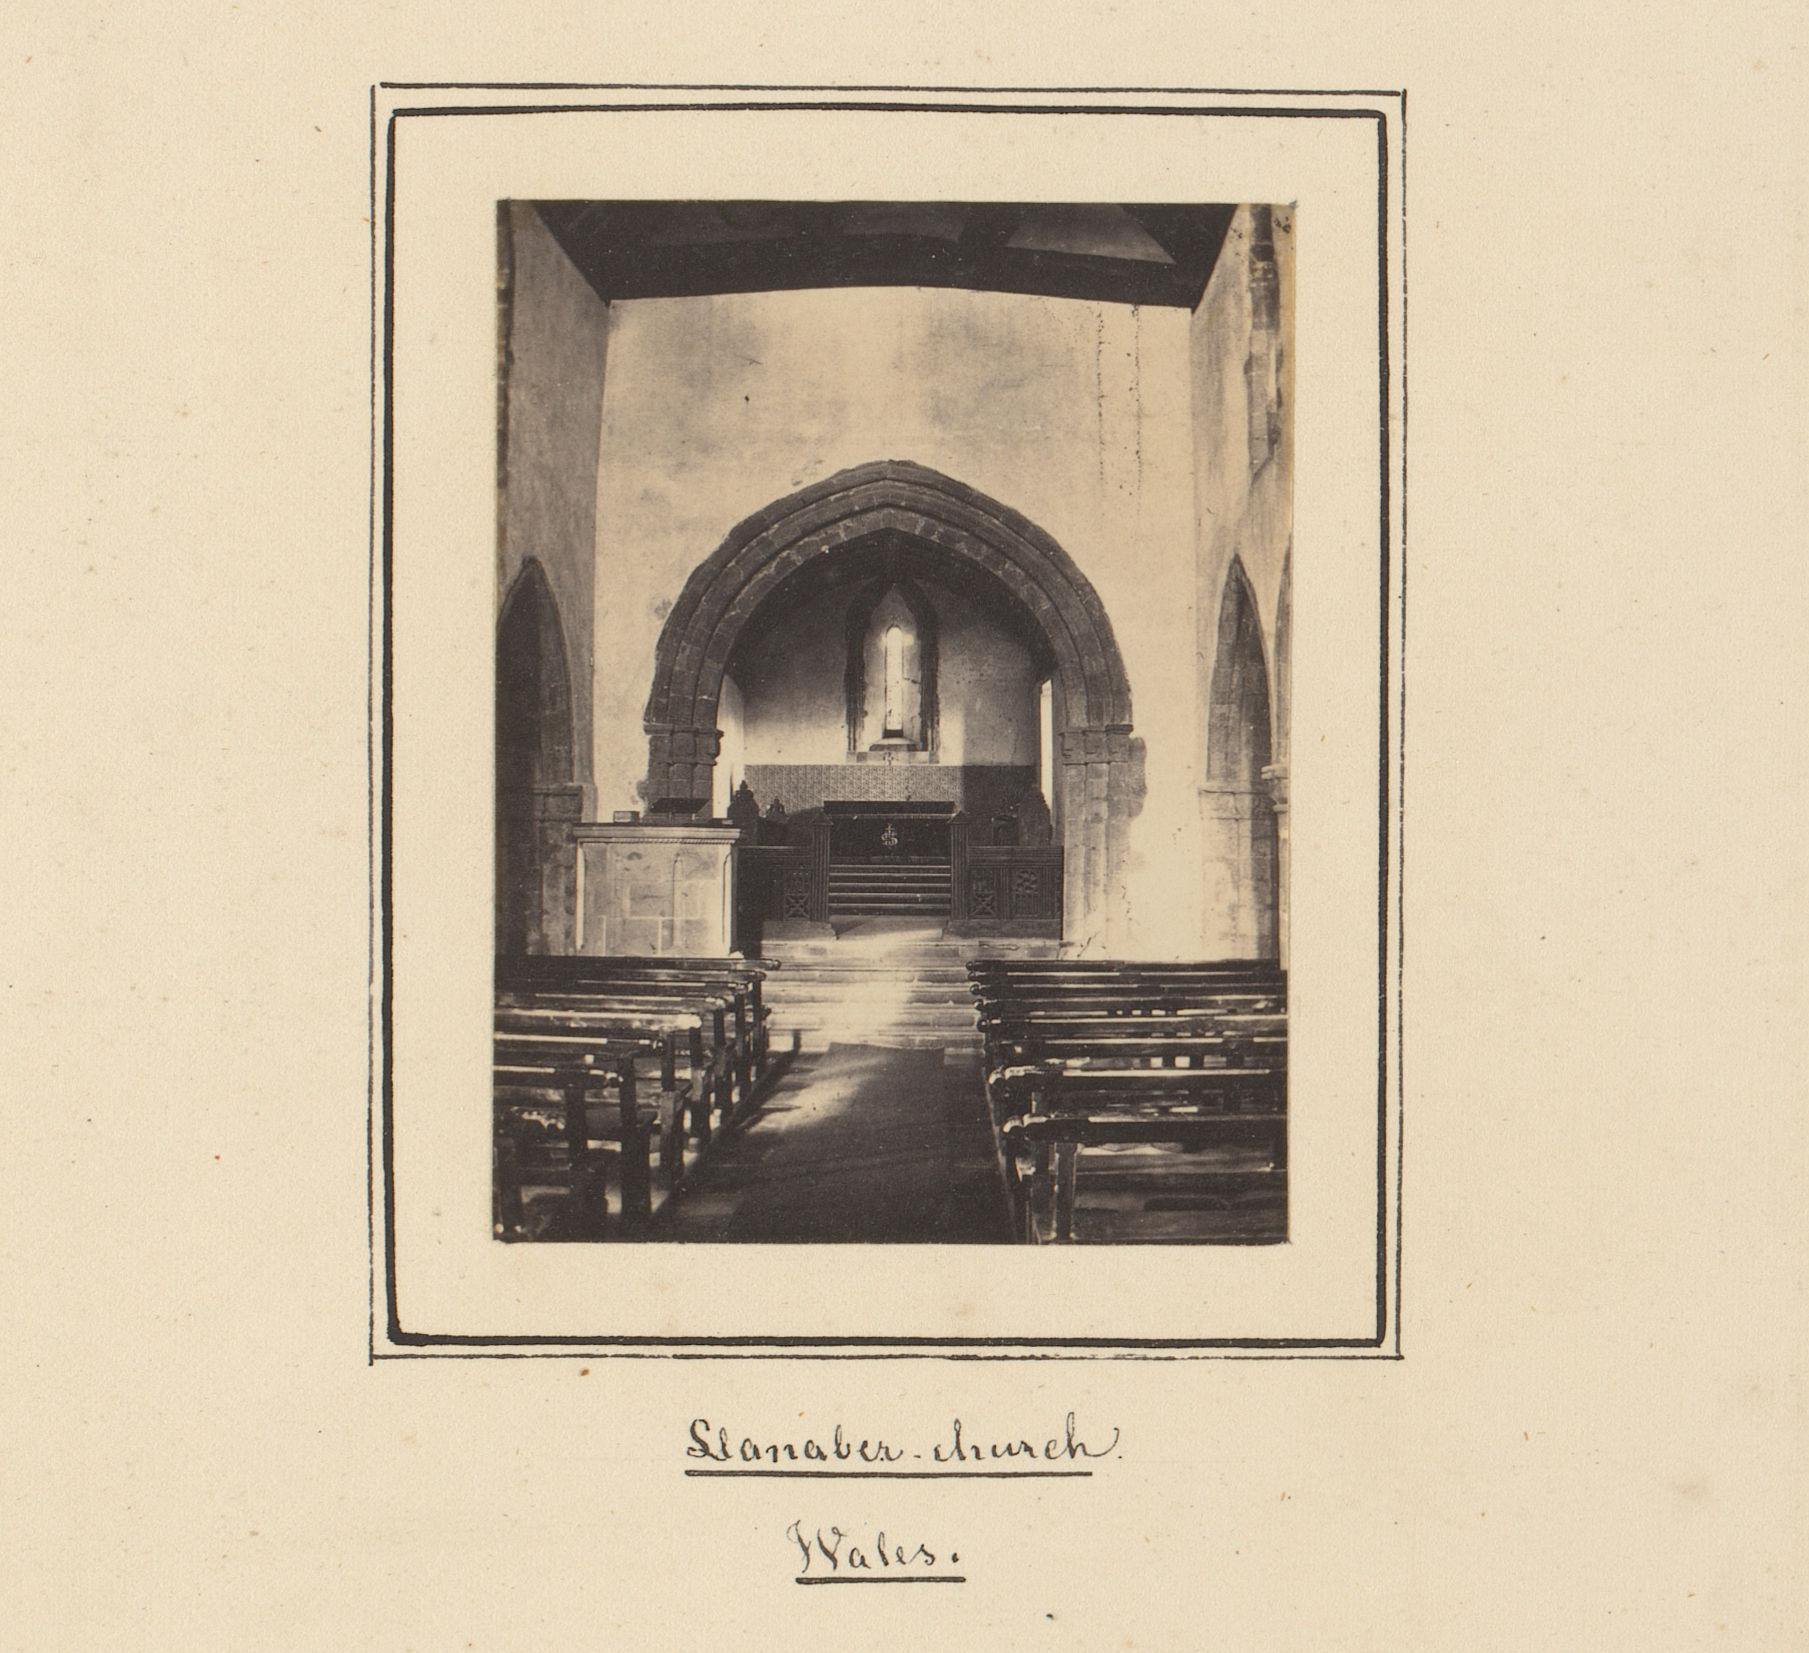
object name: photograph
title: Interieur van de Saint Mary and Saint Bodfan Church in Llanaber, Wales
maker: Anonymous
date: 1865-1890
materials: paper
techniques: albumen print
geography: llanaber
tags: interior of church